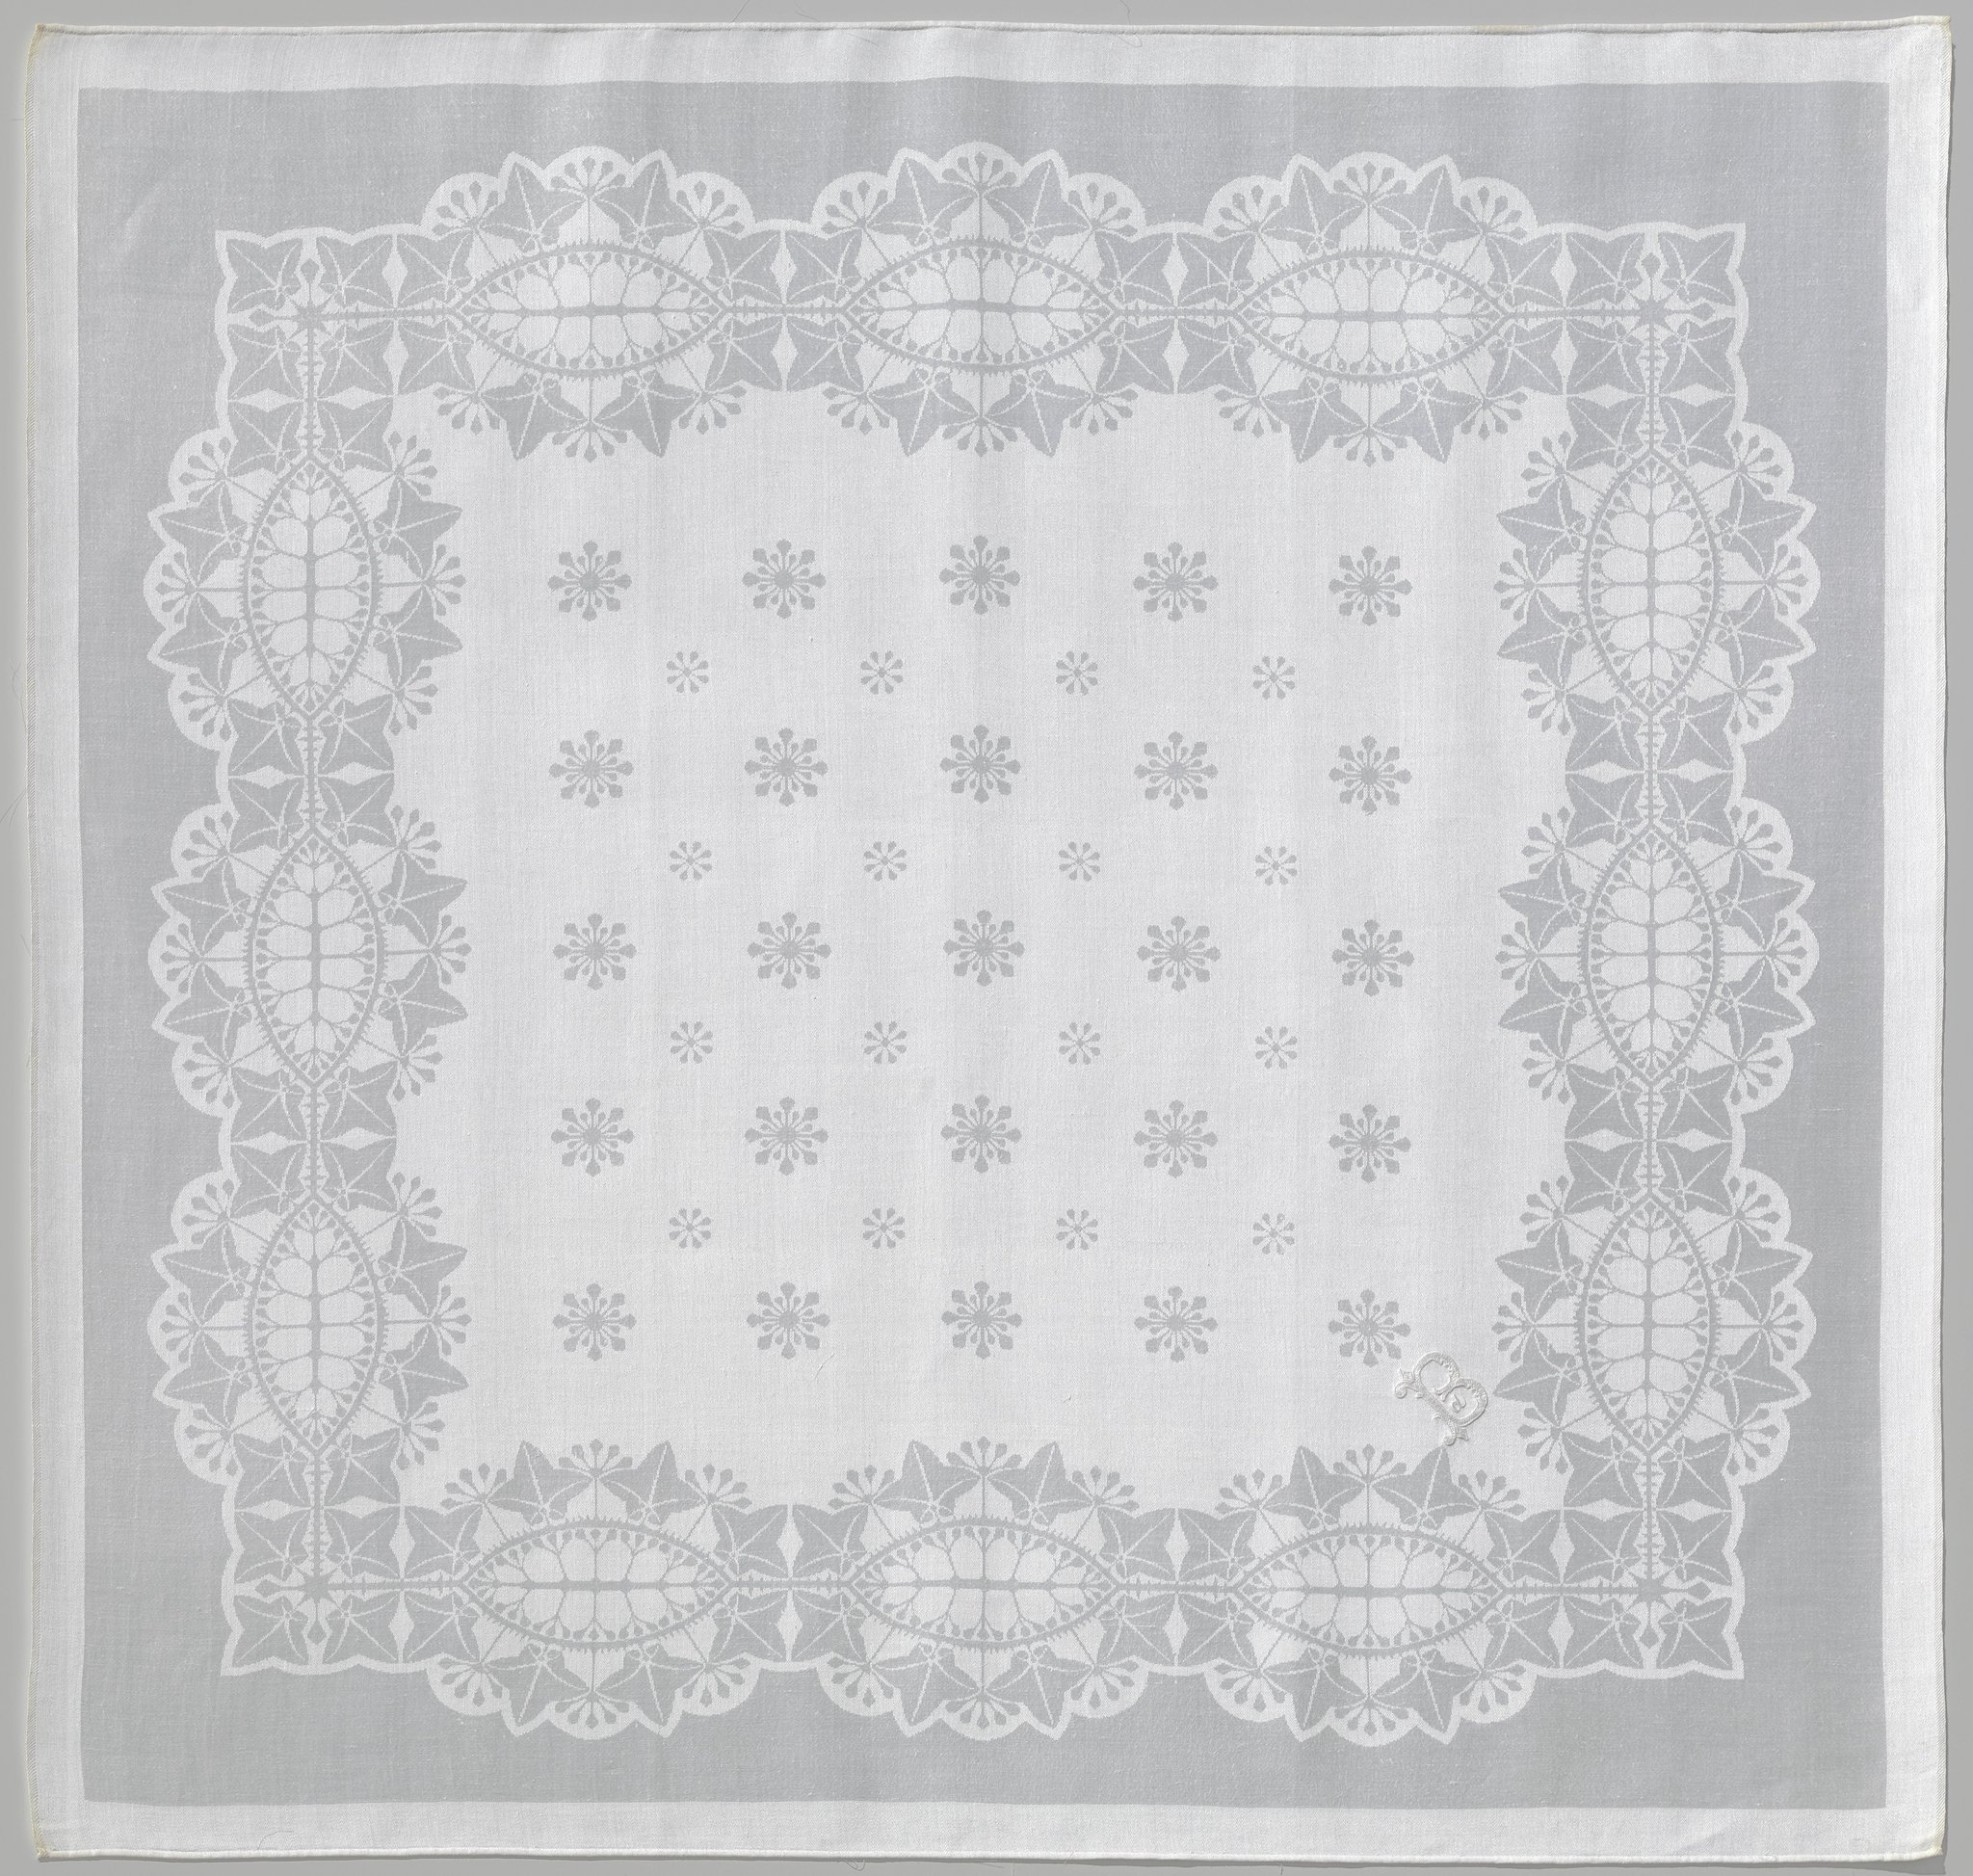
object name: napkin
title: Servet van linnendamast met klimop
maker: chris lebeau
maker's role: draughtsman, print maker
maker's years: 1878-1945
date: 1904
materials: linen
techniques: damask, weave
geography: eindhoven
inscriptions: monogram: ‘B’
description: Servet van linnendamast met klimop: motief Klimop, dessin nr. 513. Het servet hoort bij elf servetten (BK-1979-262-A t/m BK-1979-262-L) en twee tafellakens (BK-1979-261-A en BK-1979-261-B).